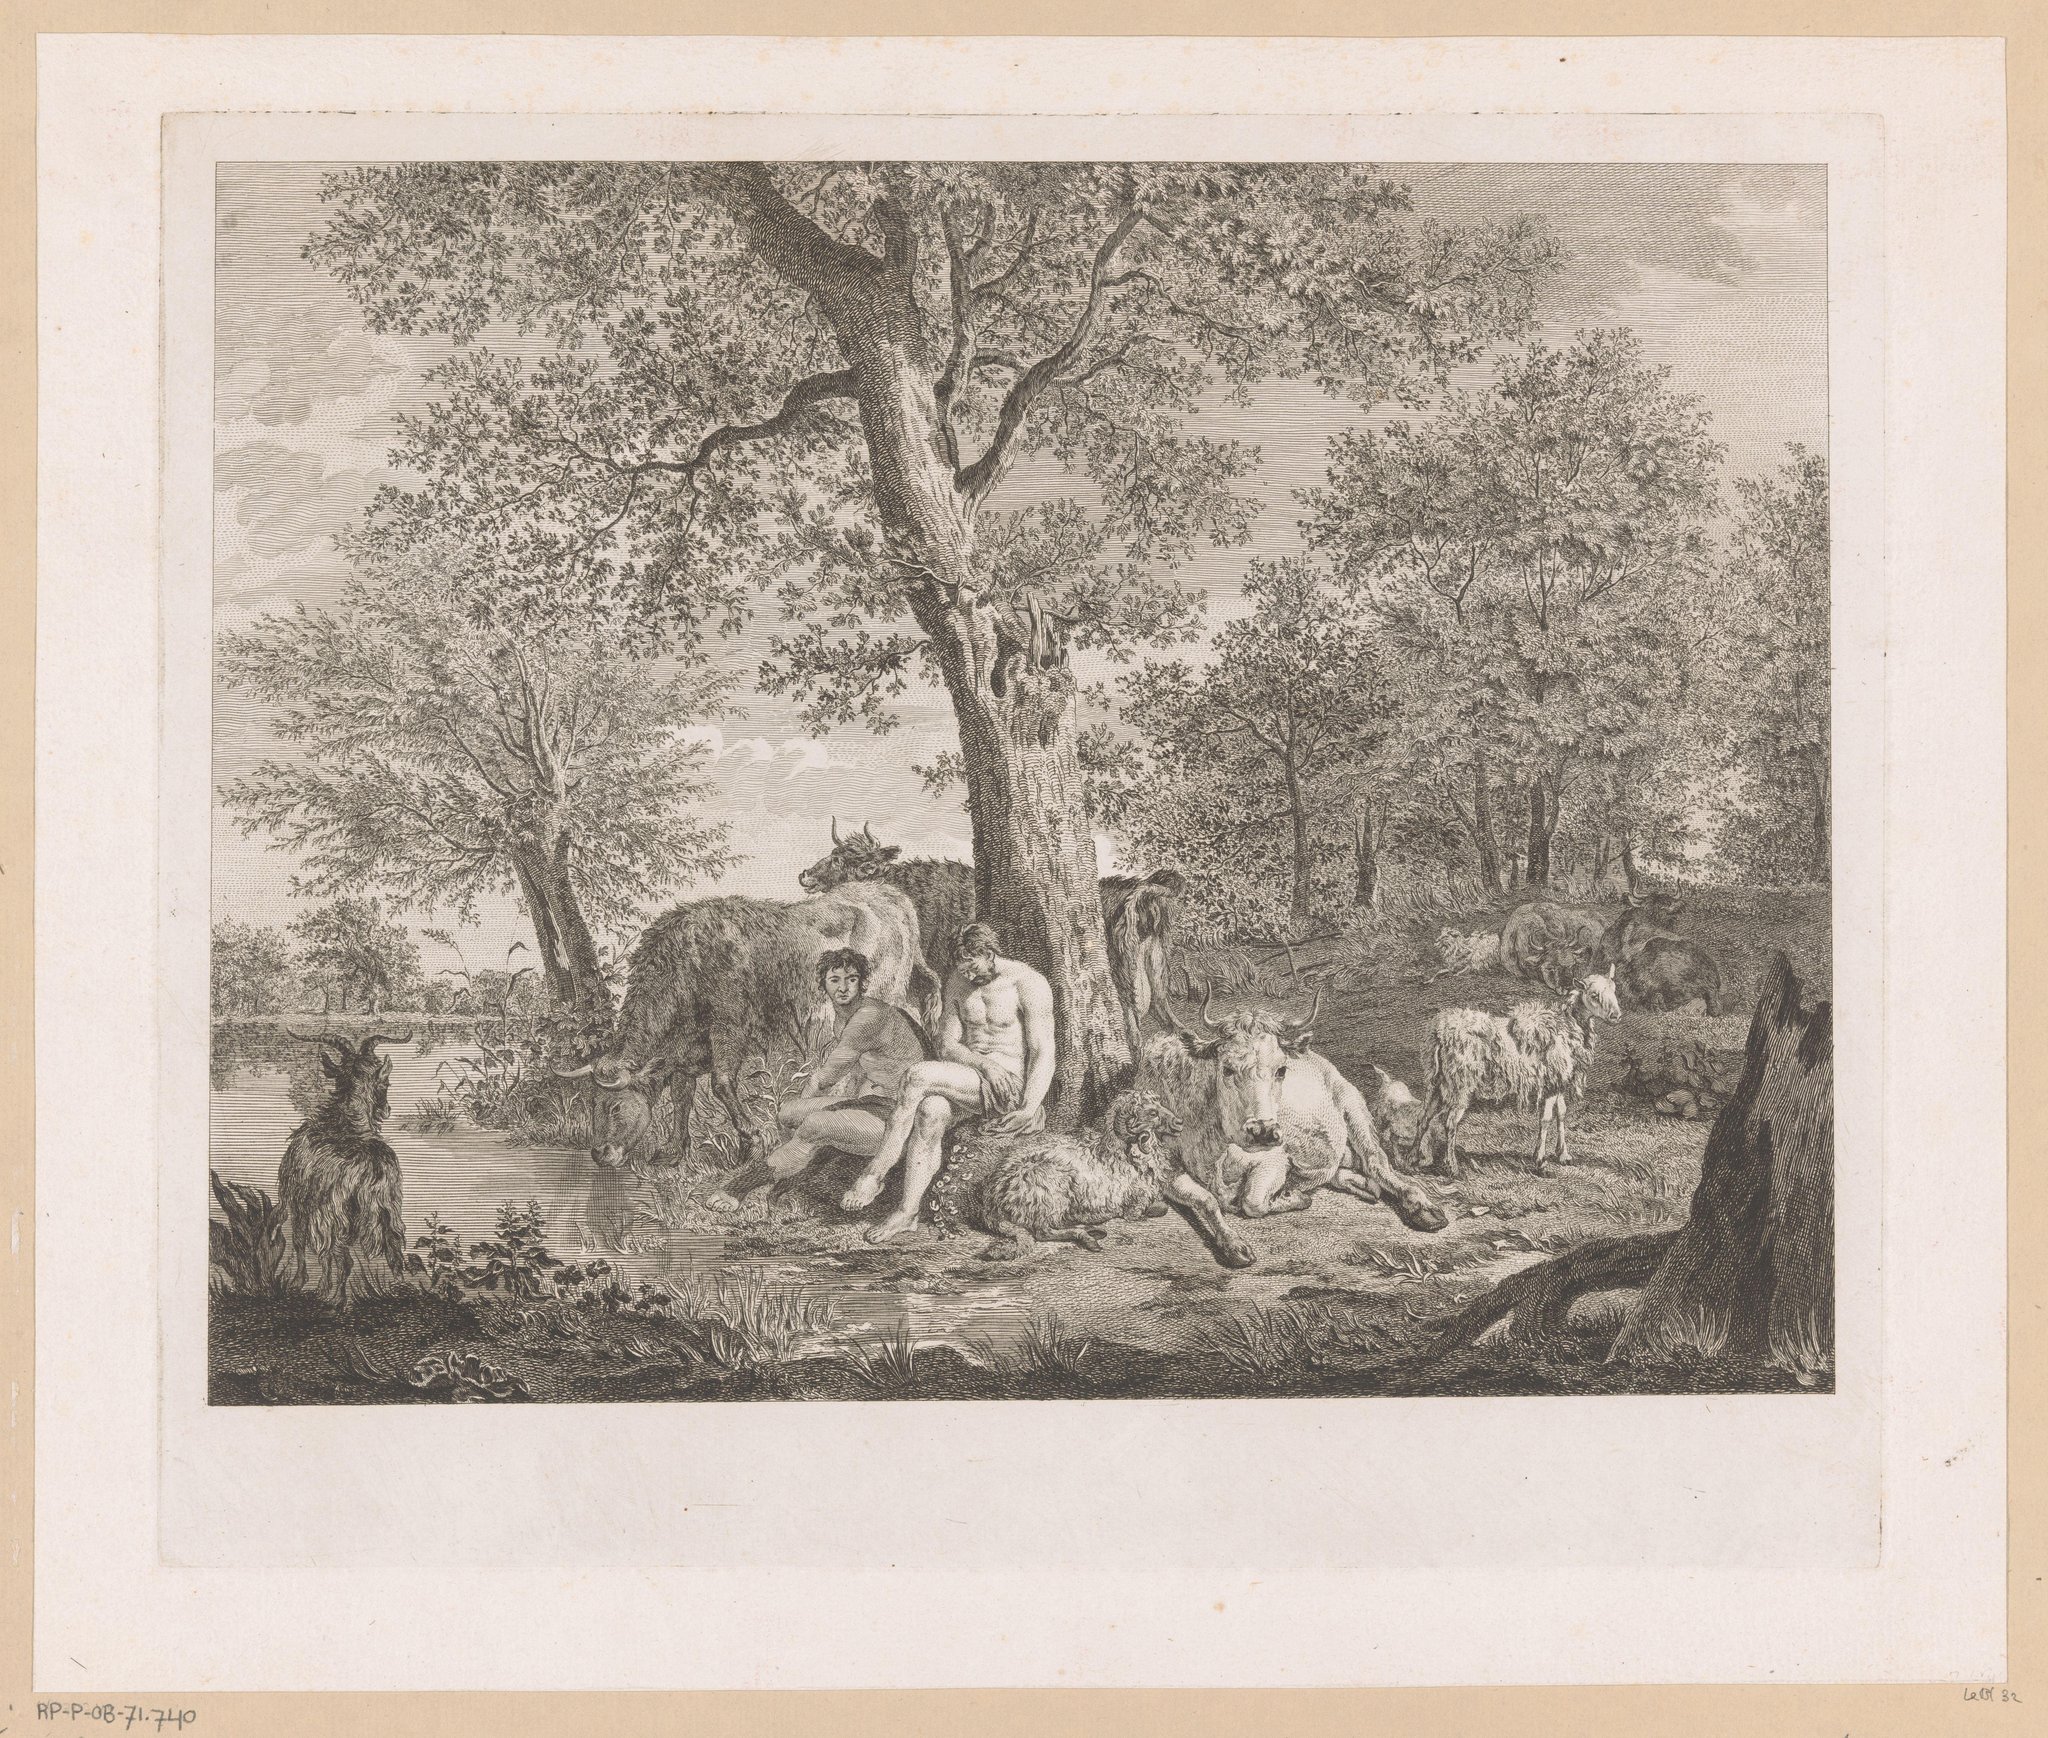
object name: print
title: Mercurius en Argus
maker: jean pelletier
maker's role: print maker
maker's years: 1736-1780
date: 1746-1780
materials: paper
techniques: engraving, etching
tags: (story of) mercury (hermes), io as a cow watched by argus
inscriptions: collector's mark: Lugt 240